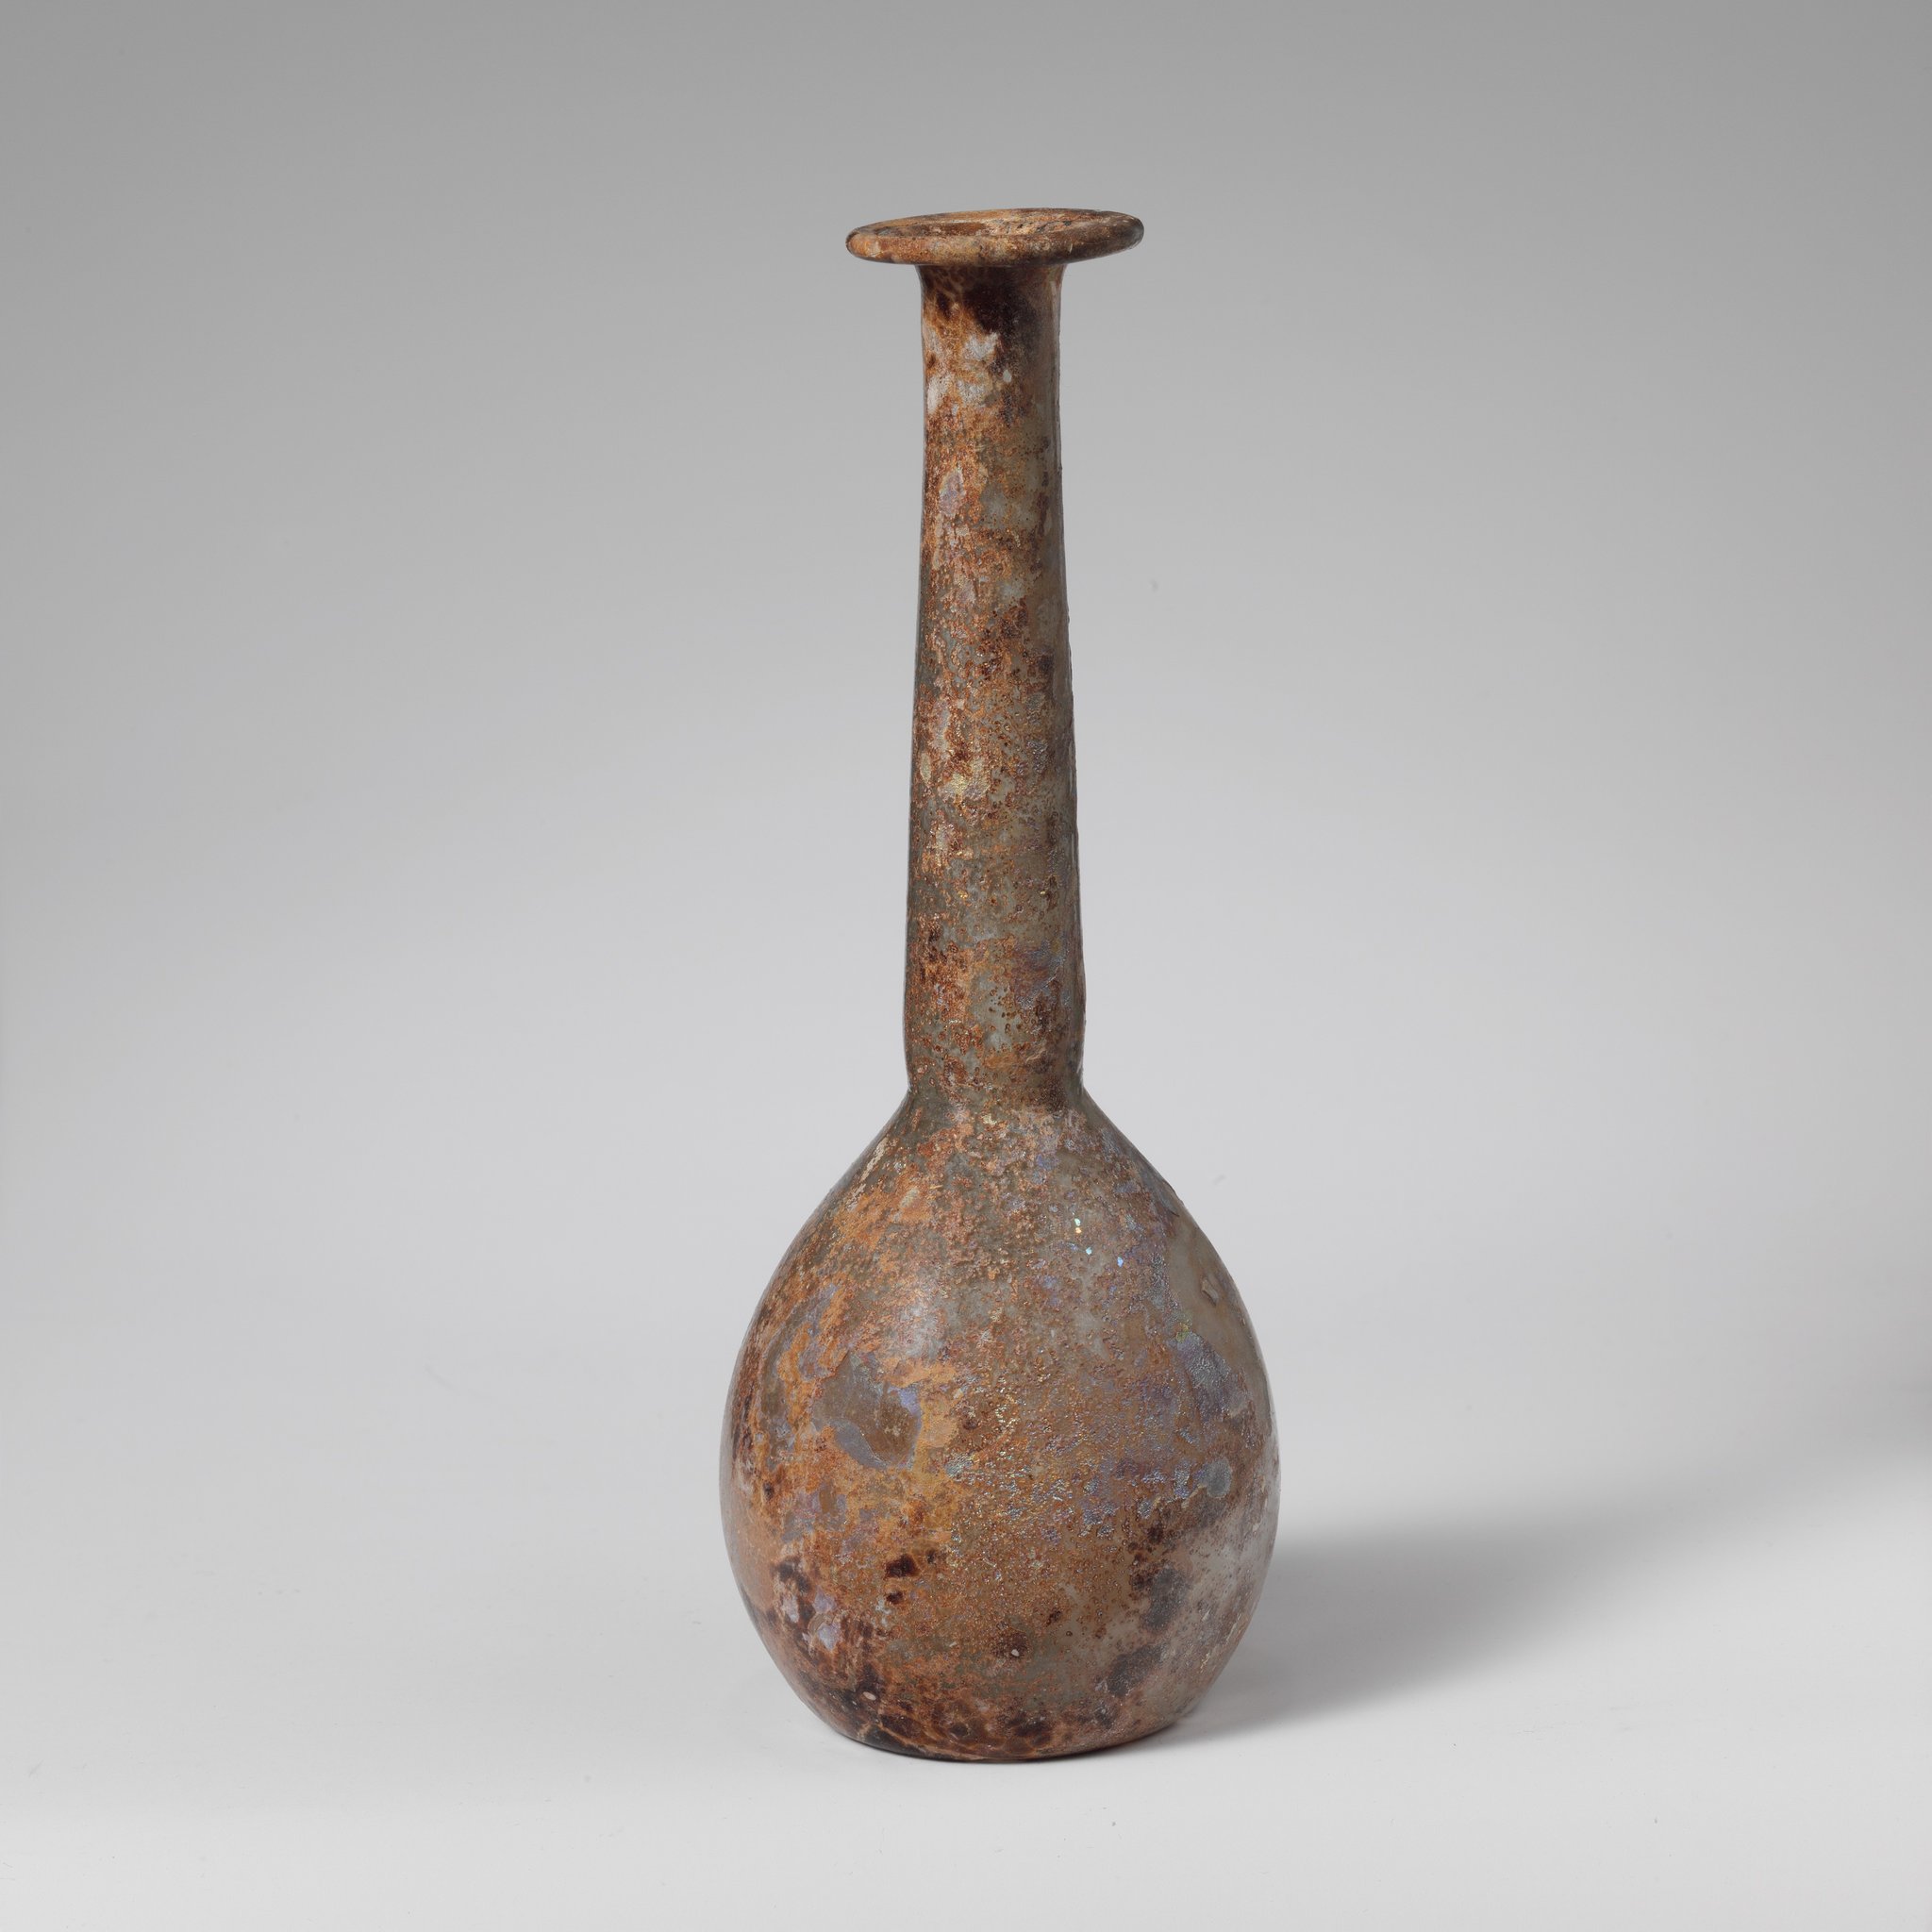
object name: perfume bottle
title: Glass perfume bottle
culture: roman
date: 101-300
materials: glass